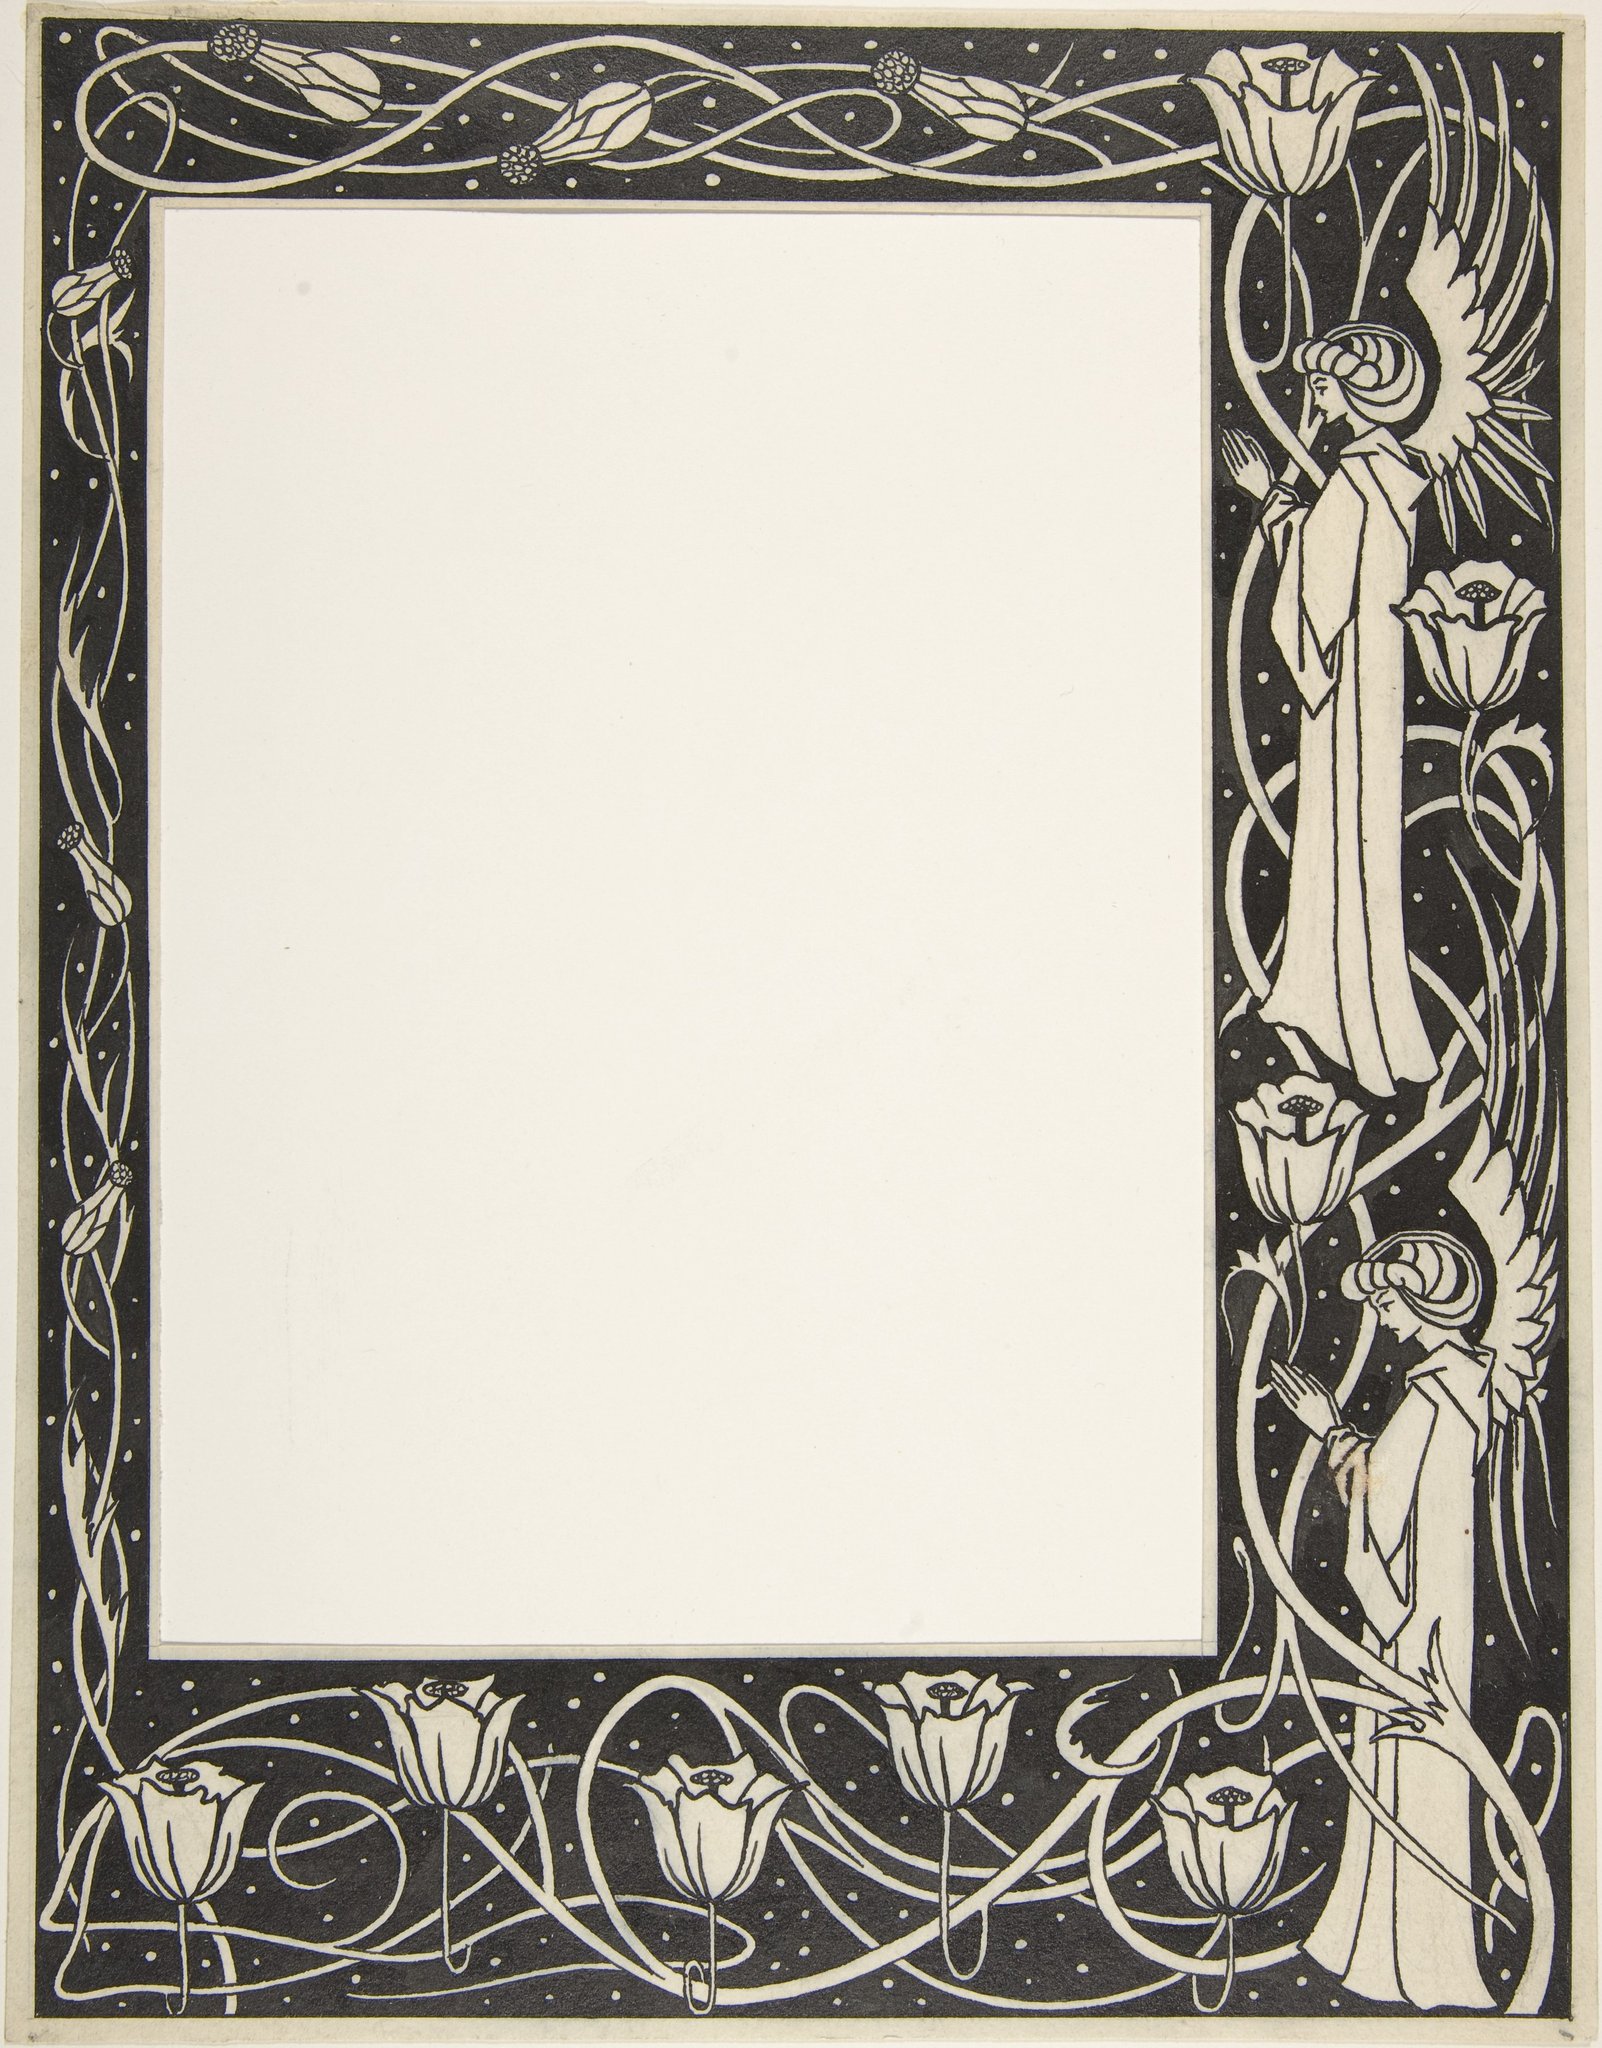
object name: drawing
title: Praying Angels and Poppies (Border Design for Thomas Malory, "Le Morte d'Arthur," J. M. Dent 1893–94, Part III, book vii, chapter i, p. 219)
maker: aubrey vincent beardsley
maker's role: artist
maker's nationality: british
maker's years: 1872-1898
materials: ink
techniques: brush, pen, wash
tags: flowers,angels